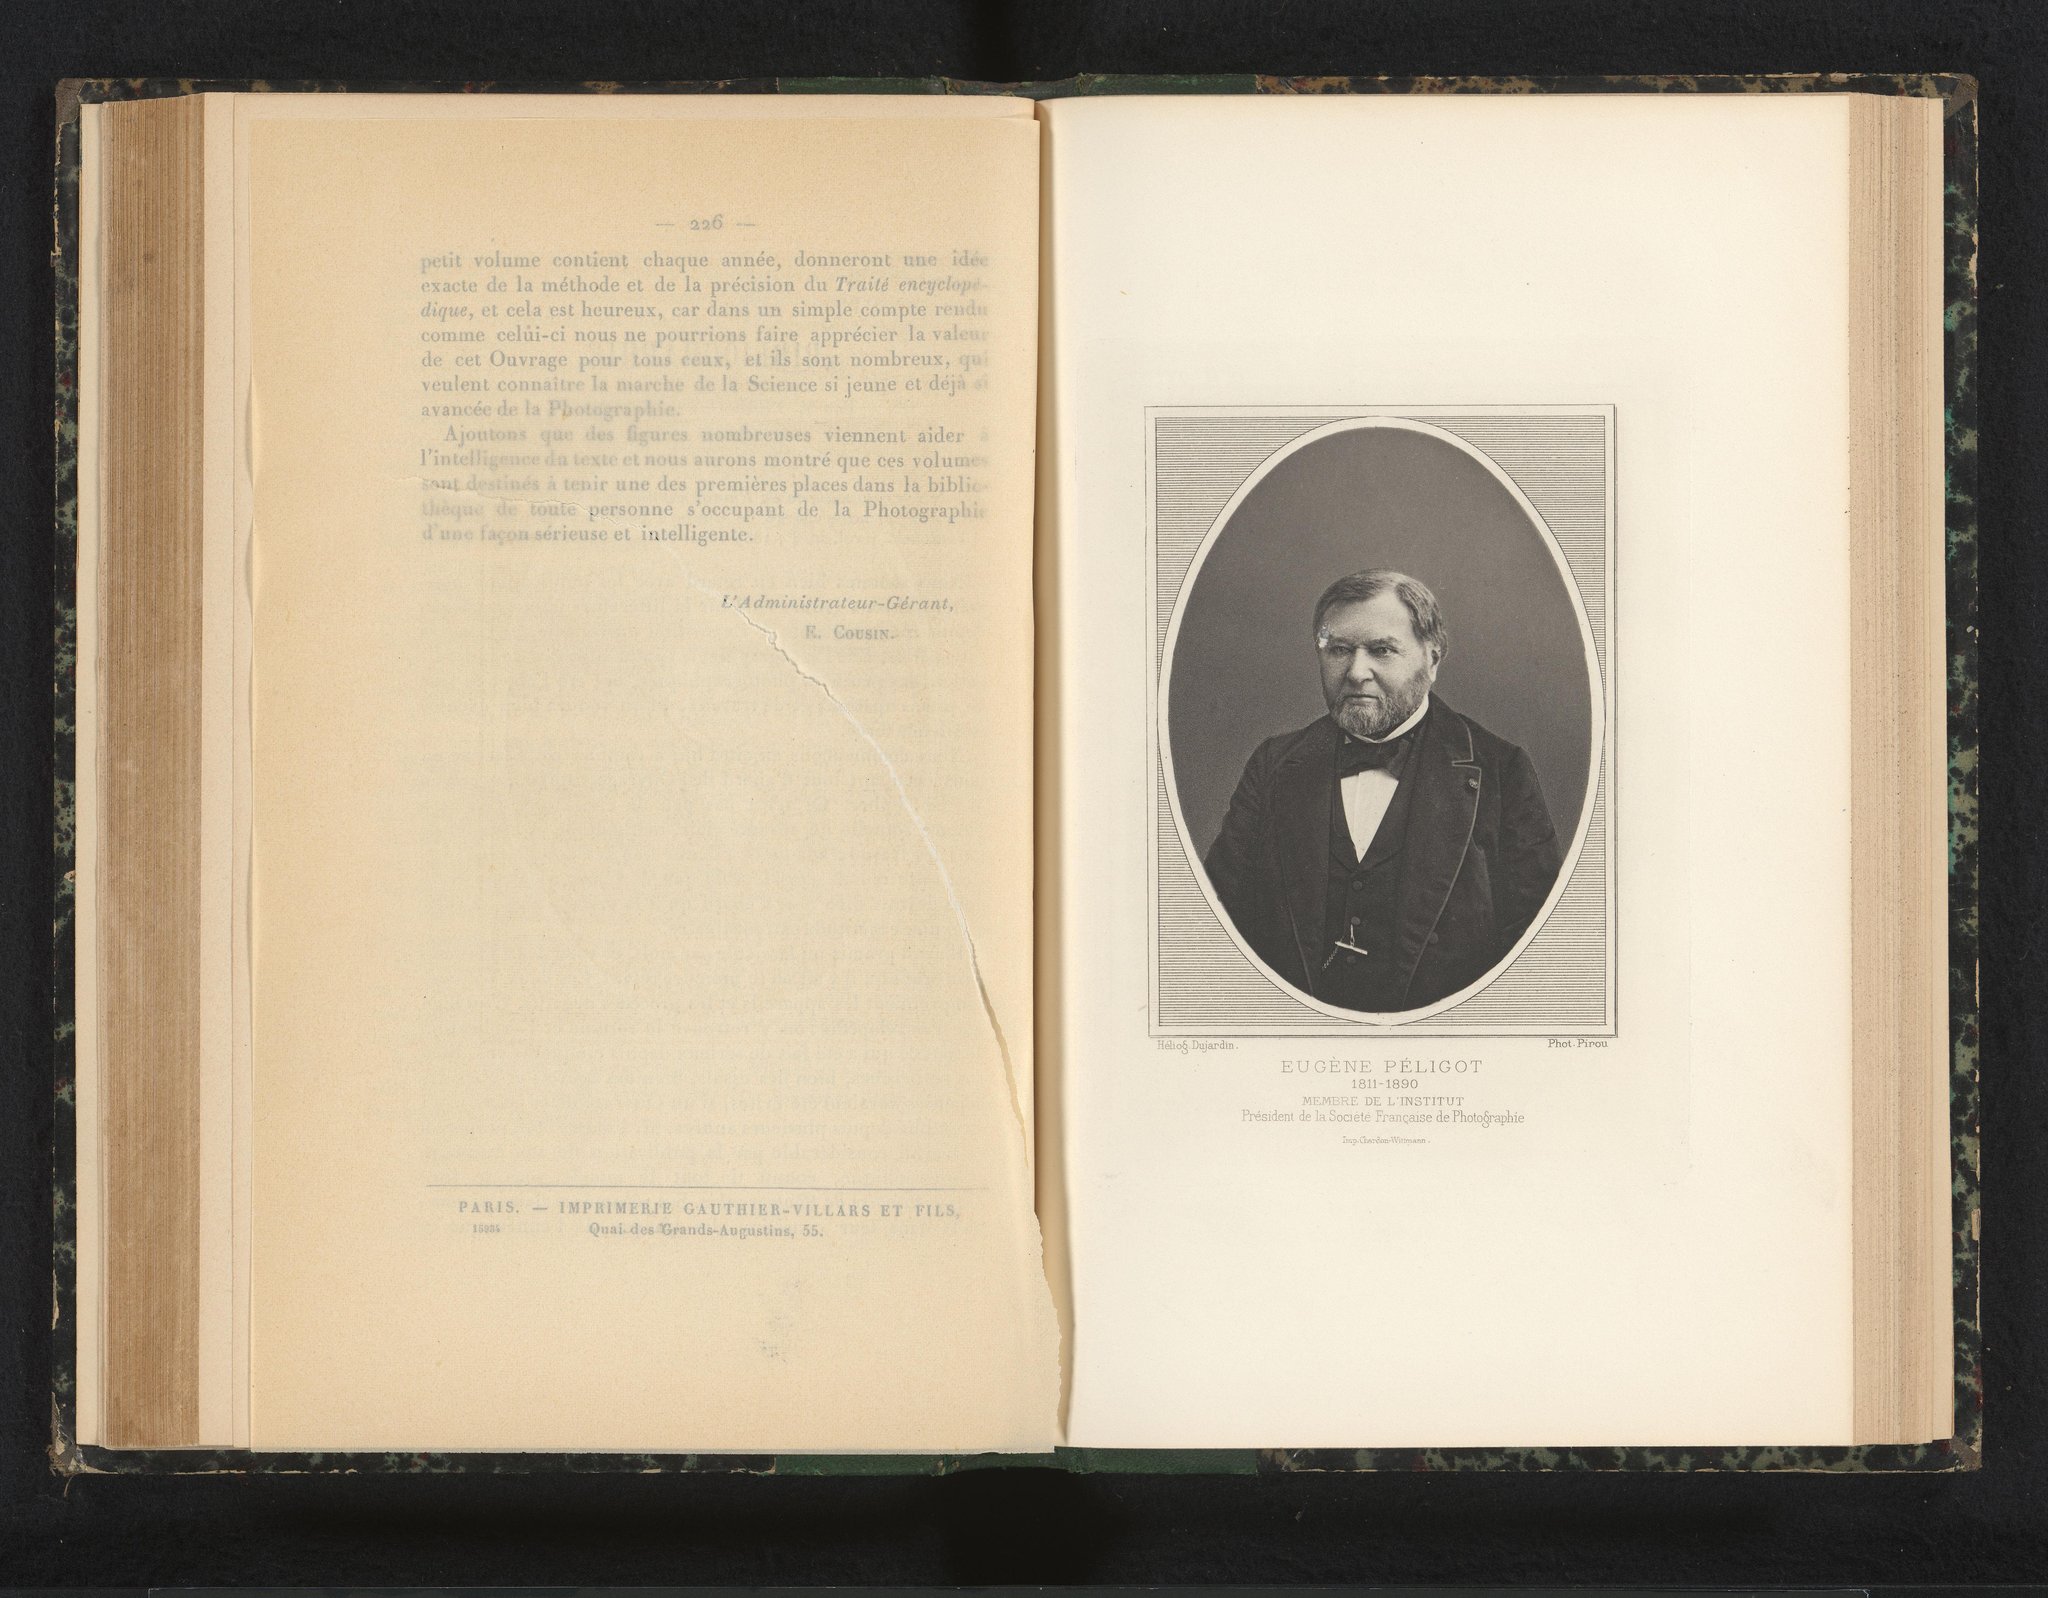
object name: photomechanical print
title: Portret van Eugène Péligot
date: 1885-1890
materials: paper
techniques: engraving, photoaquatint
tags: historical persons, portrait, self-portrait of photographer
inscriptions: inscription: ‘Membre de l'institut/ Président de la Société Française de Photographie’